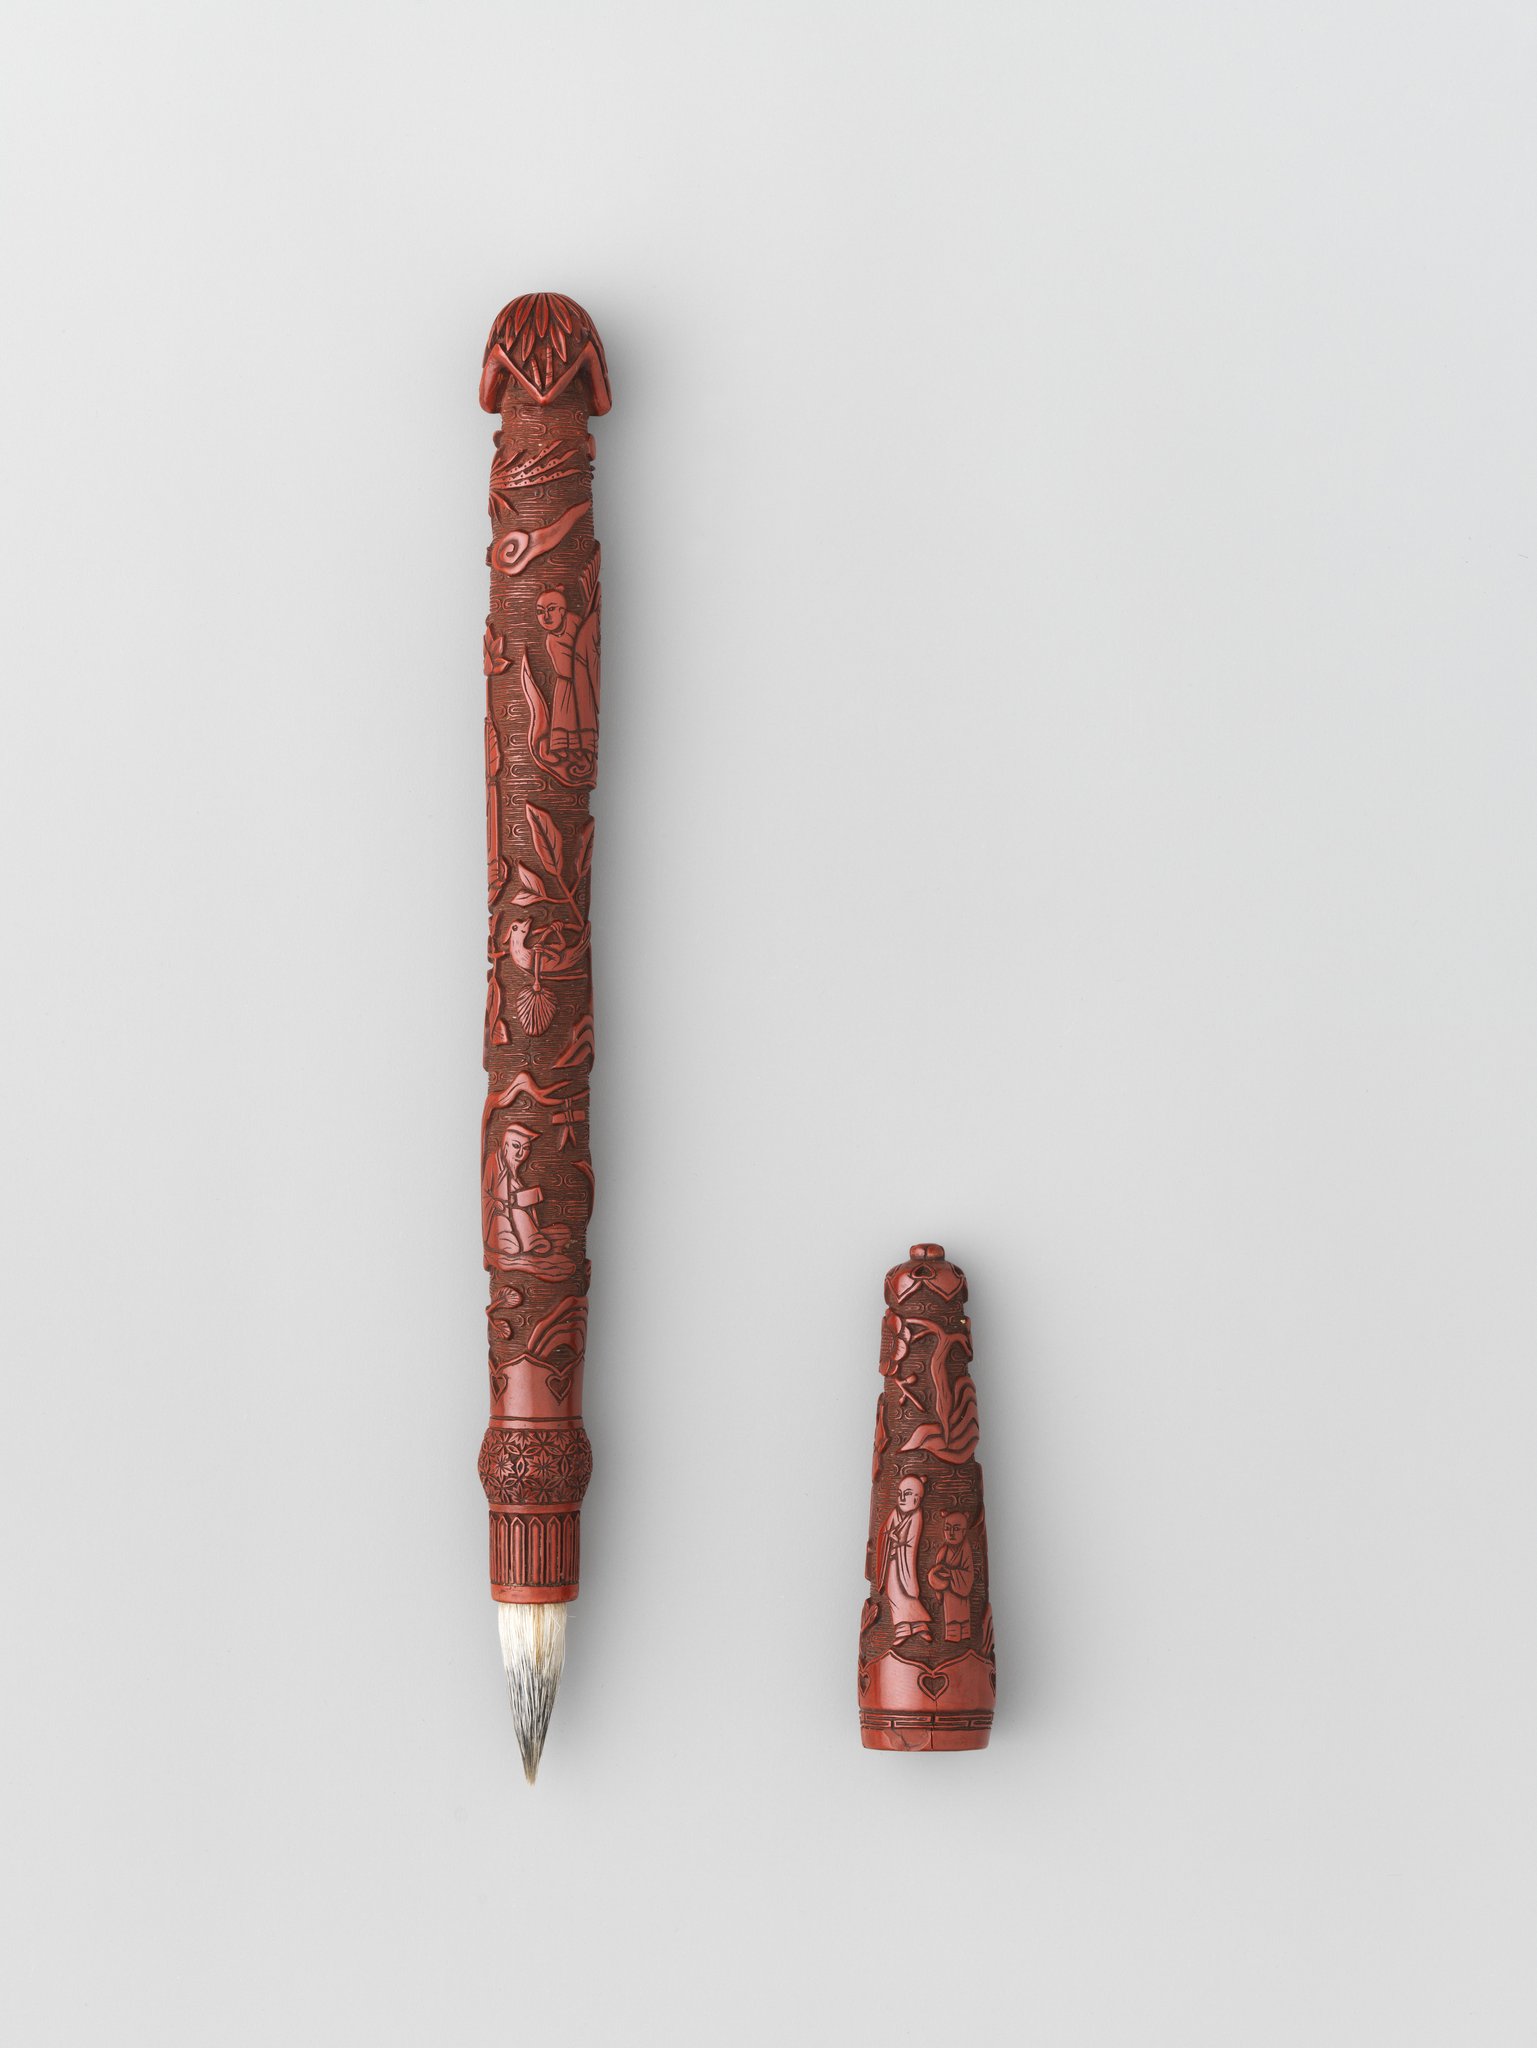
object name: writing brush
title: Writing brush and cover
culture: chinese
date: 1567-1600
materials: lacquer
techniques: carving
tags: animals,men